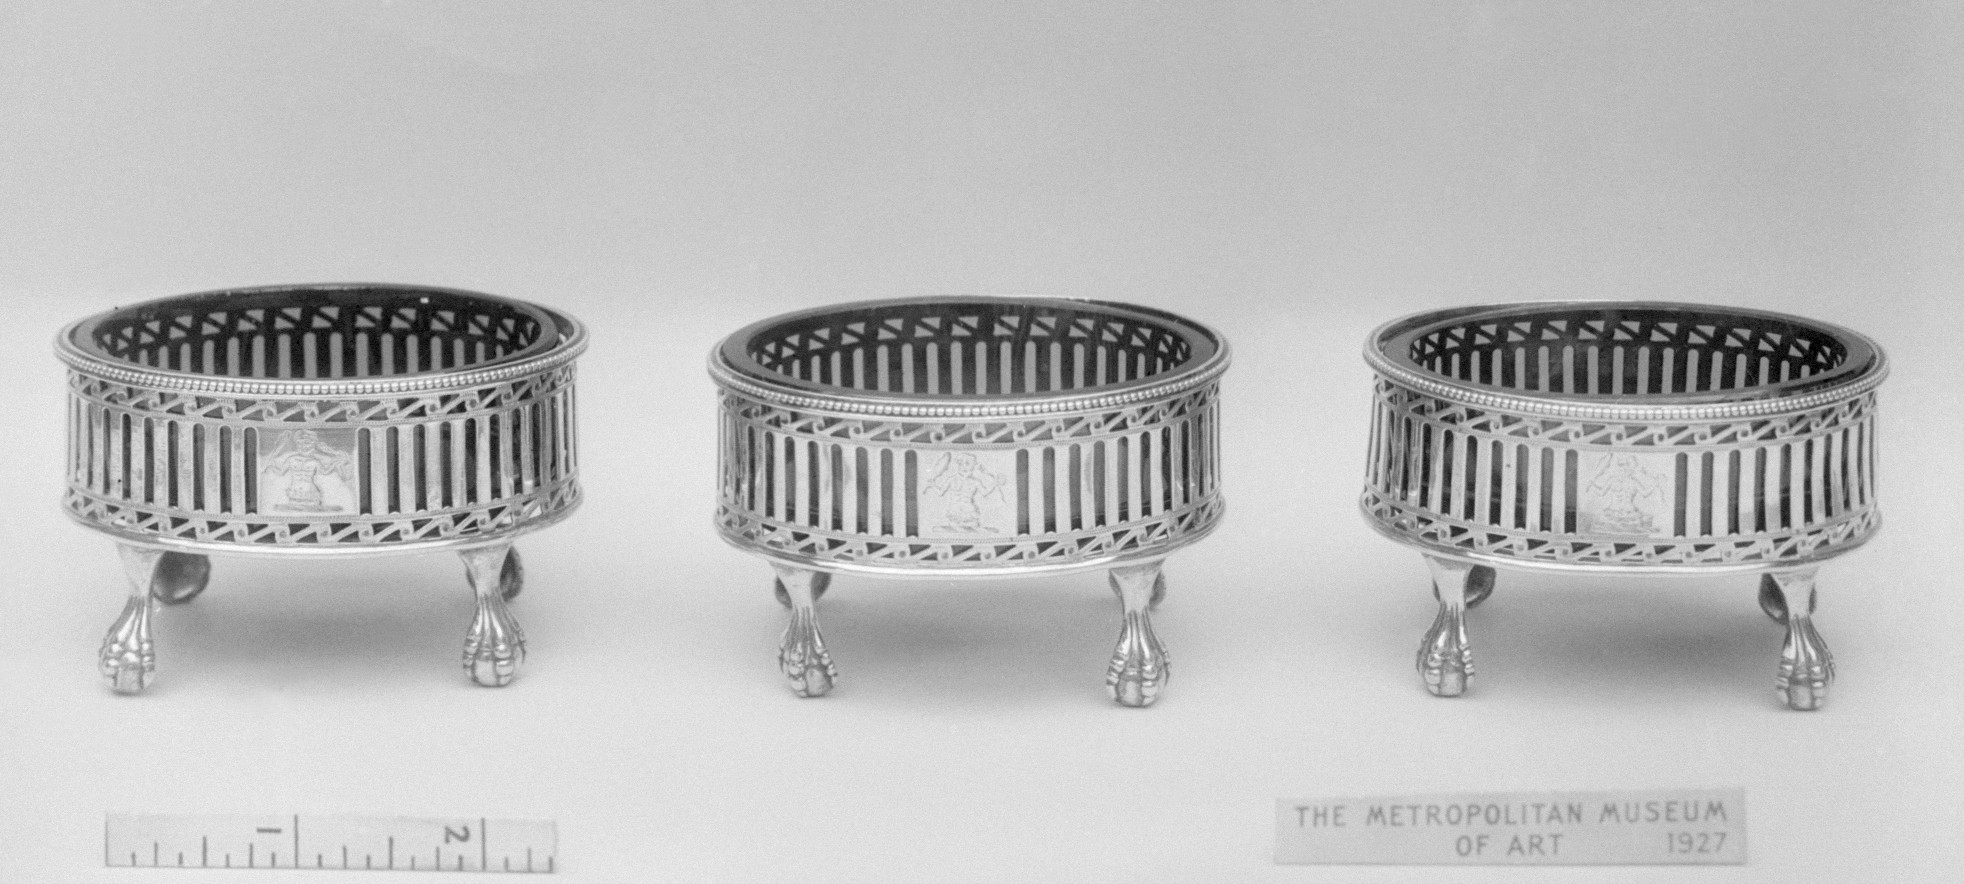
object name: saltcellar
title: Three saltcellars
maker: robert hennell i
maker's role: maker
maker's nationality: british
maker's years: 1741-1811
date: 1783-1784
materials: glass, silver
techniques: lining